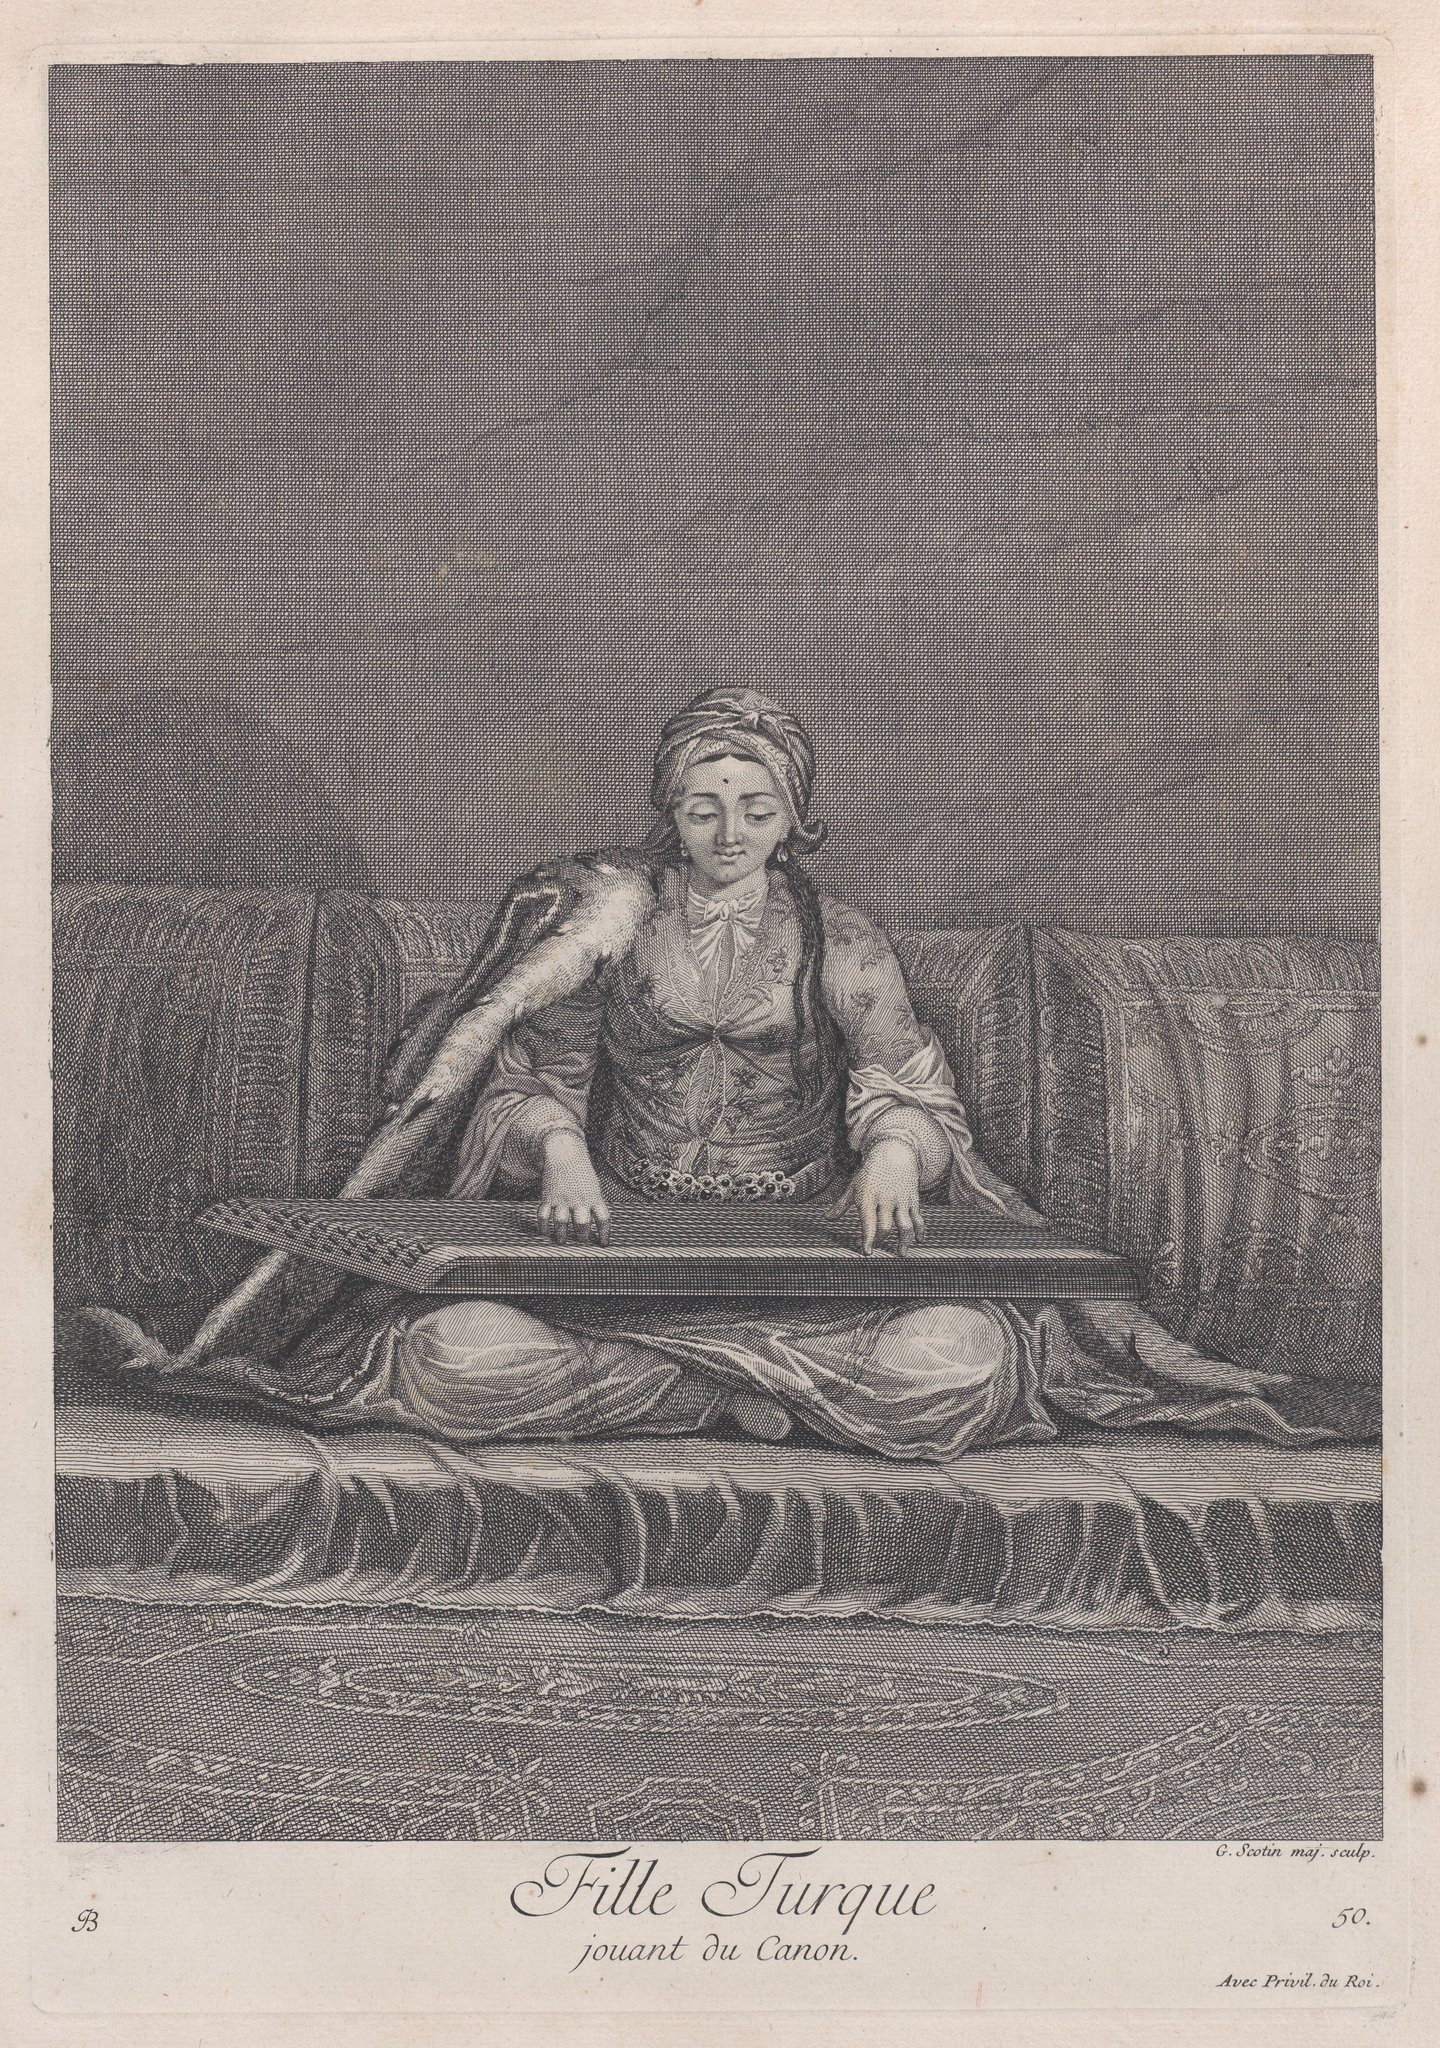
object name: print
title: Fille Turque, jouant du Canon, plate 50 from "Recueil de cent estampes représentent differentes nations du Levant"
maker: jean baptiste vanmour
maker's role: artist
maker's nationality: french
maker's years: 1671-1737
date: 1714-1715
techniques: engraving, etching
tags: women